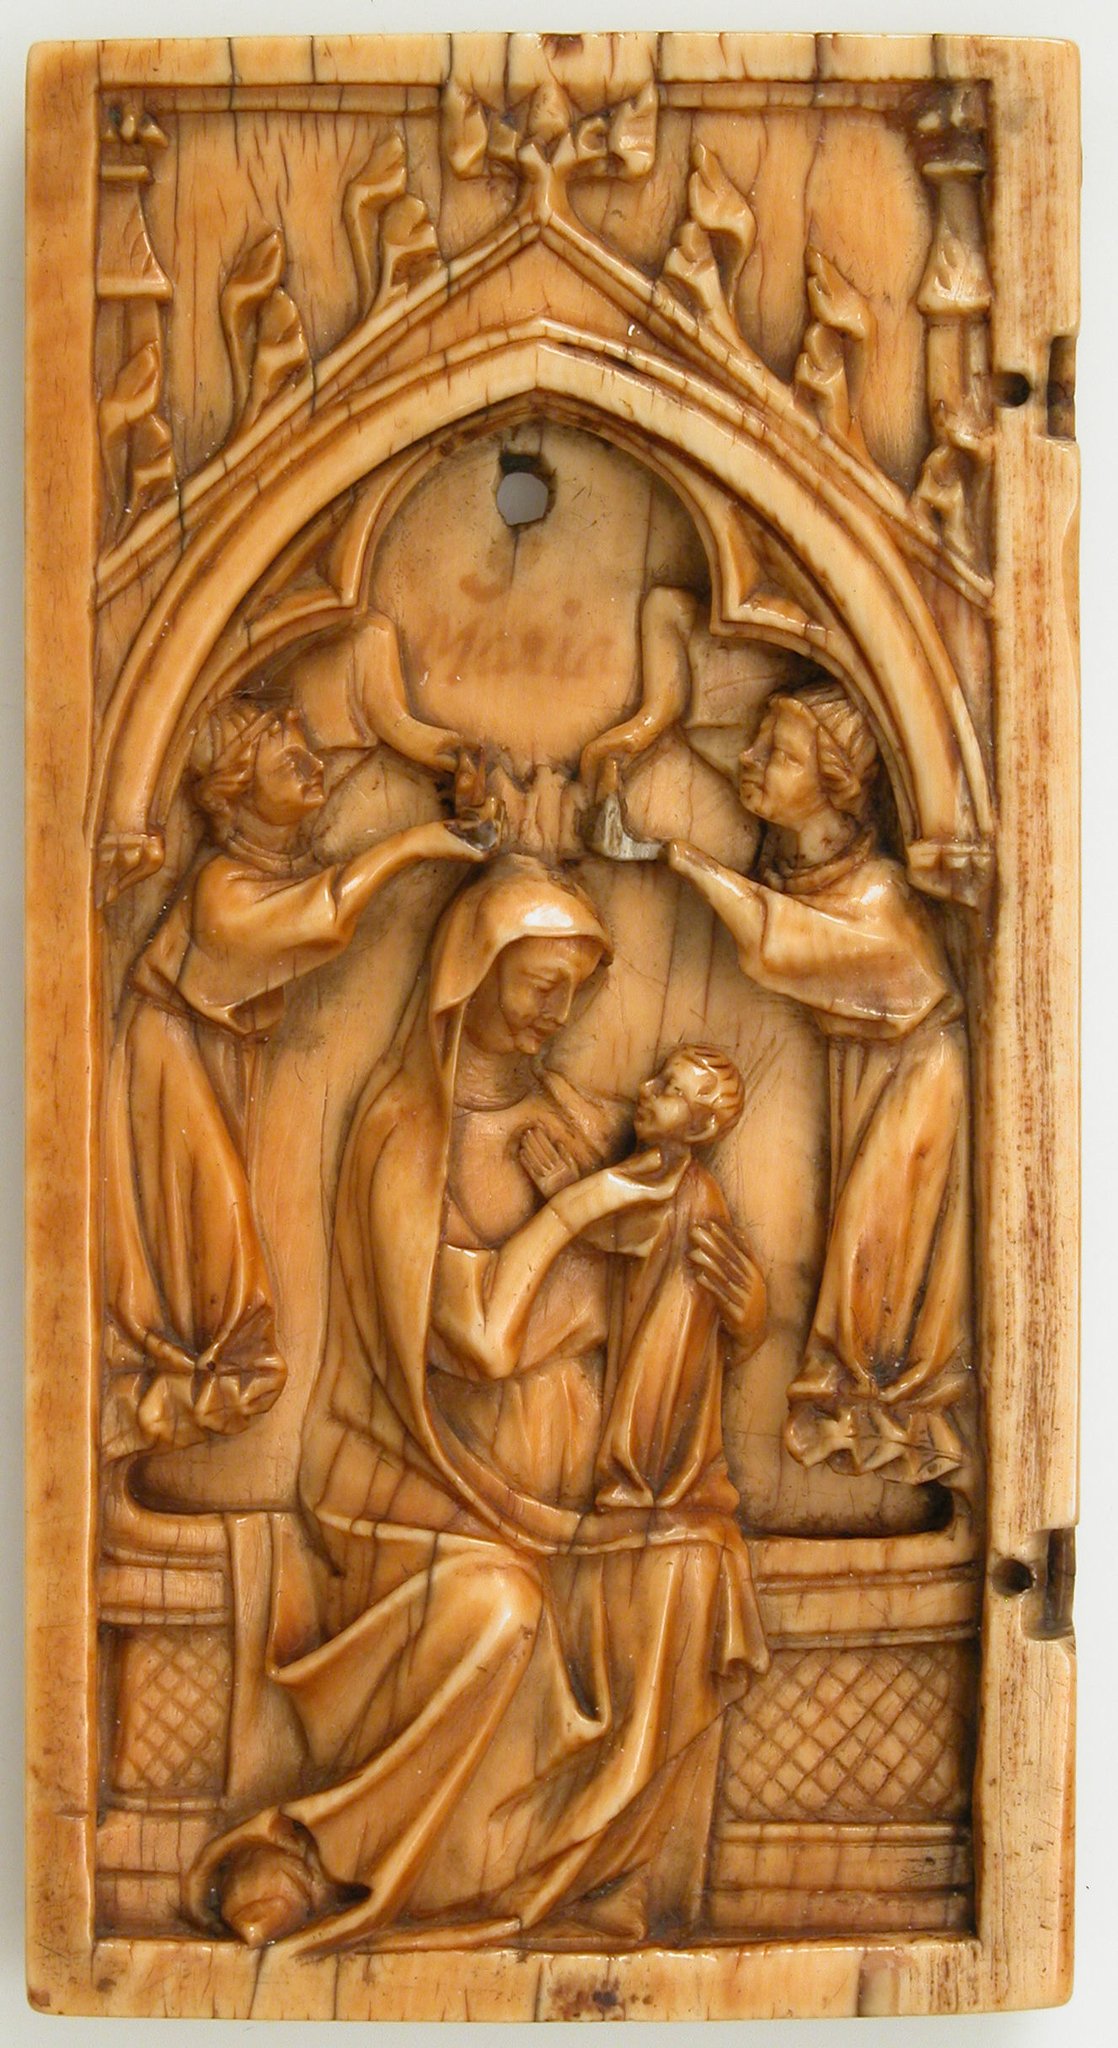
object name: diptych leaf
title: Leaf from a Diptych with the Virgin and Child and Angels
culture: french, north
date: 1340-1360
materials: ivory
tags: angels